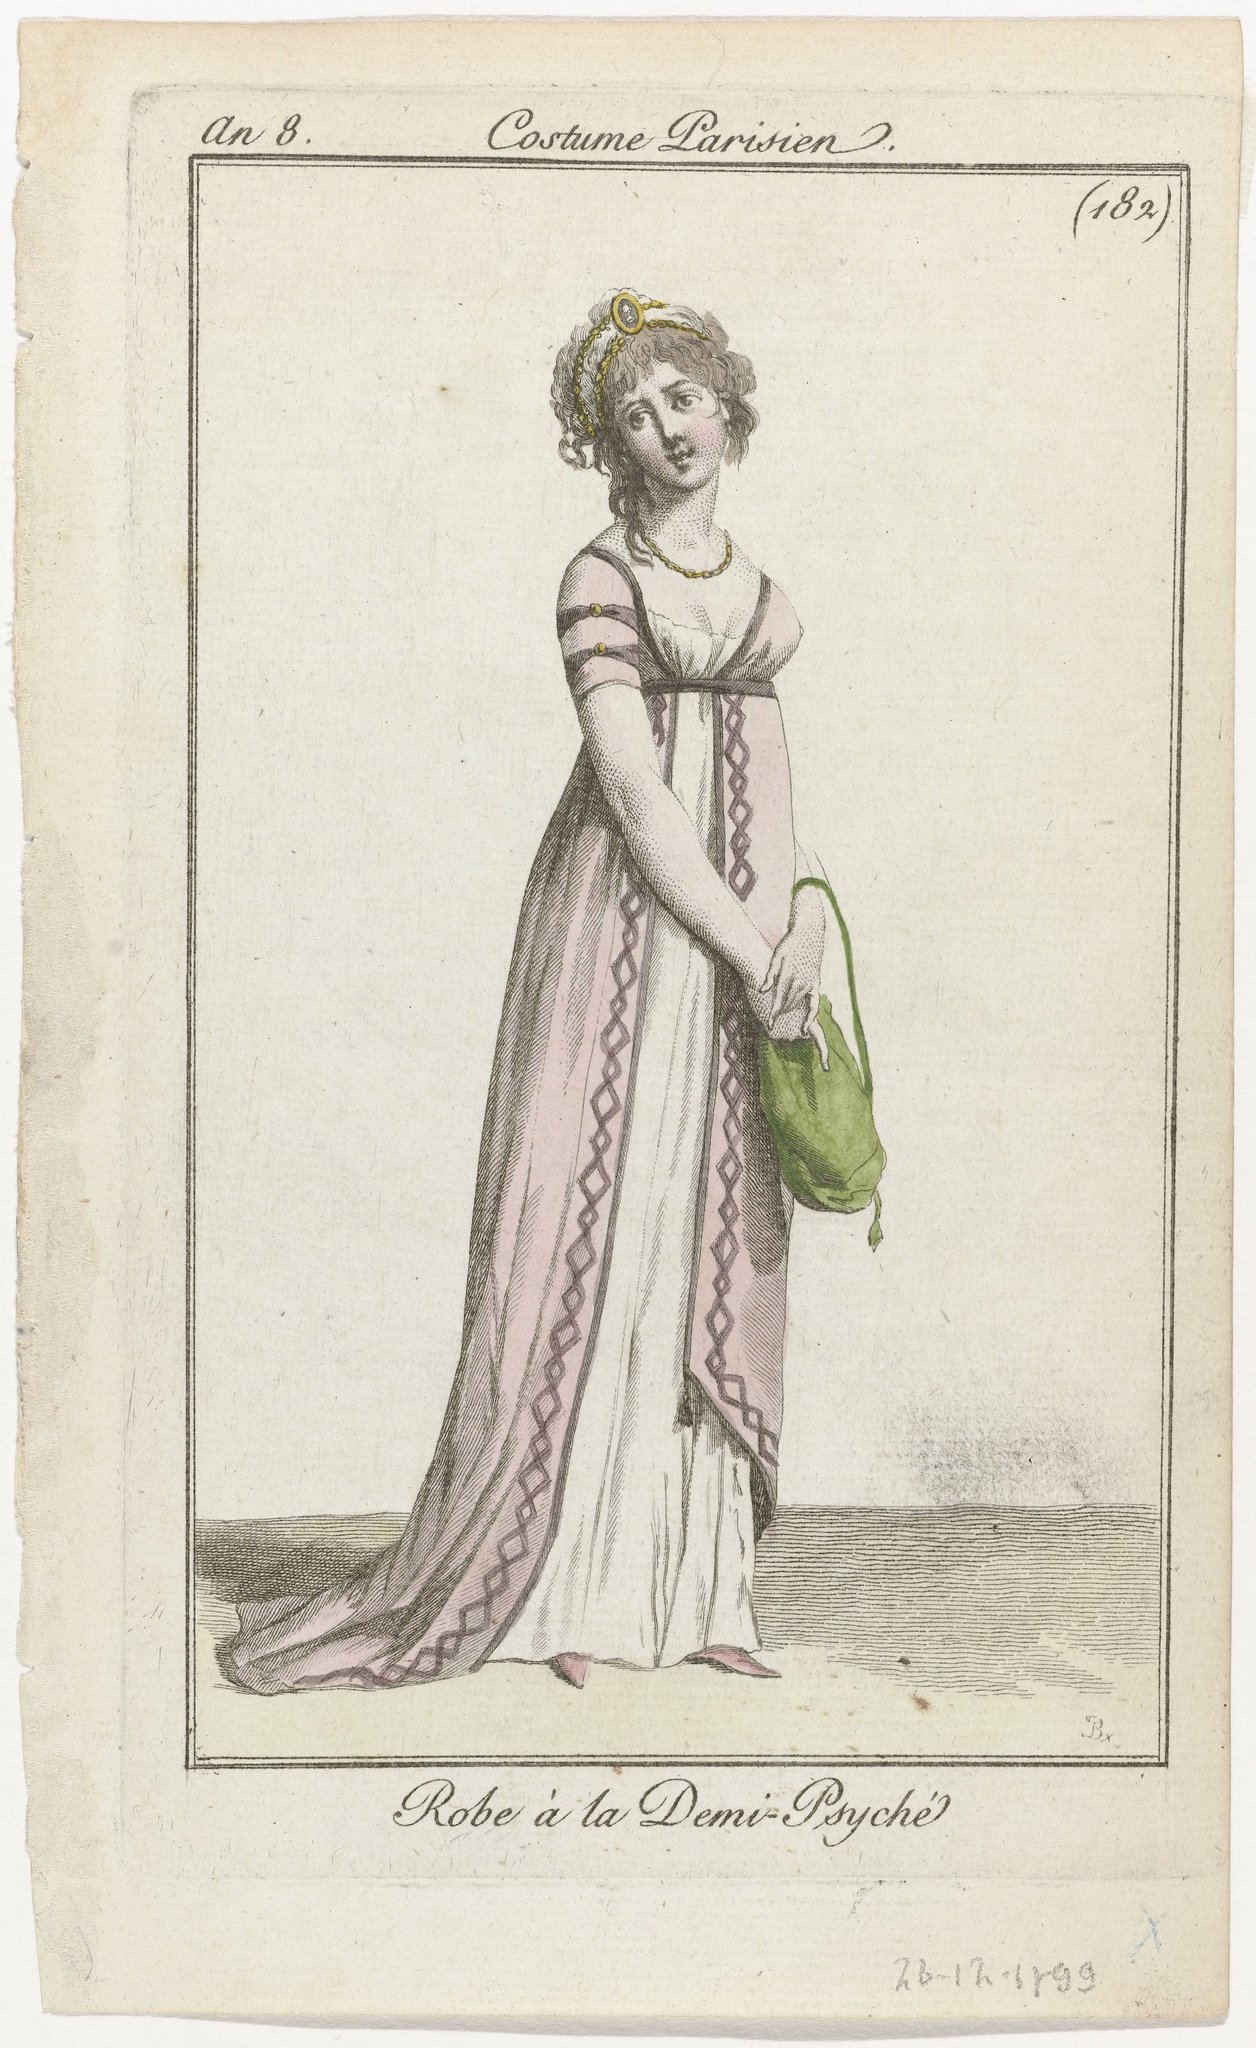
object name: fashion print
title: Journal des Dames et des Modes, Costume Parisien, 26 décembre 1799, An 8, (182) : Robe à la Demi-Psyché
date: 1799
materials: paper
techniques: engraving, hand coloring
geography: paris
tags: diadem, tiara (+ women's clothes), bag (reticule) (+ women's clothes), fashion plates, dress, gown (+ women's clothes), necklace (+ women's clothes)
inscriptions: title: ‘Costume Parisien.’, caption: ‘Robe à la Demi-Psyché’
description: Staande vrouw gekleed in een japon 'à la Demi-Psyché', bij de zoom versierd met geometrische motief. Accessoires: haarband met ovaal medaillon, collier, reticule of buidel, platte schoenen met puntige neuzen. De prent maakt deel uit van het modetijdschrift Journal des Dames et des Modes, uitgegeven door Pierre de la Mésangère, Parijs, 1797-1839.